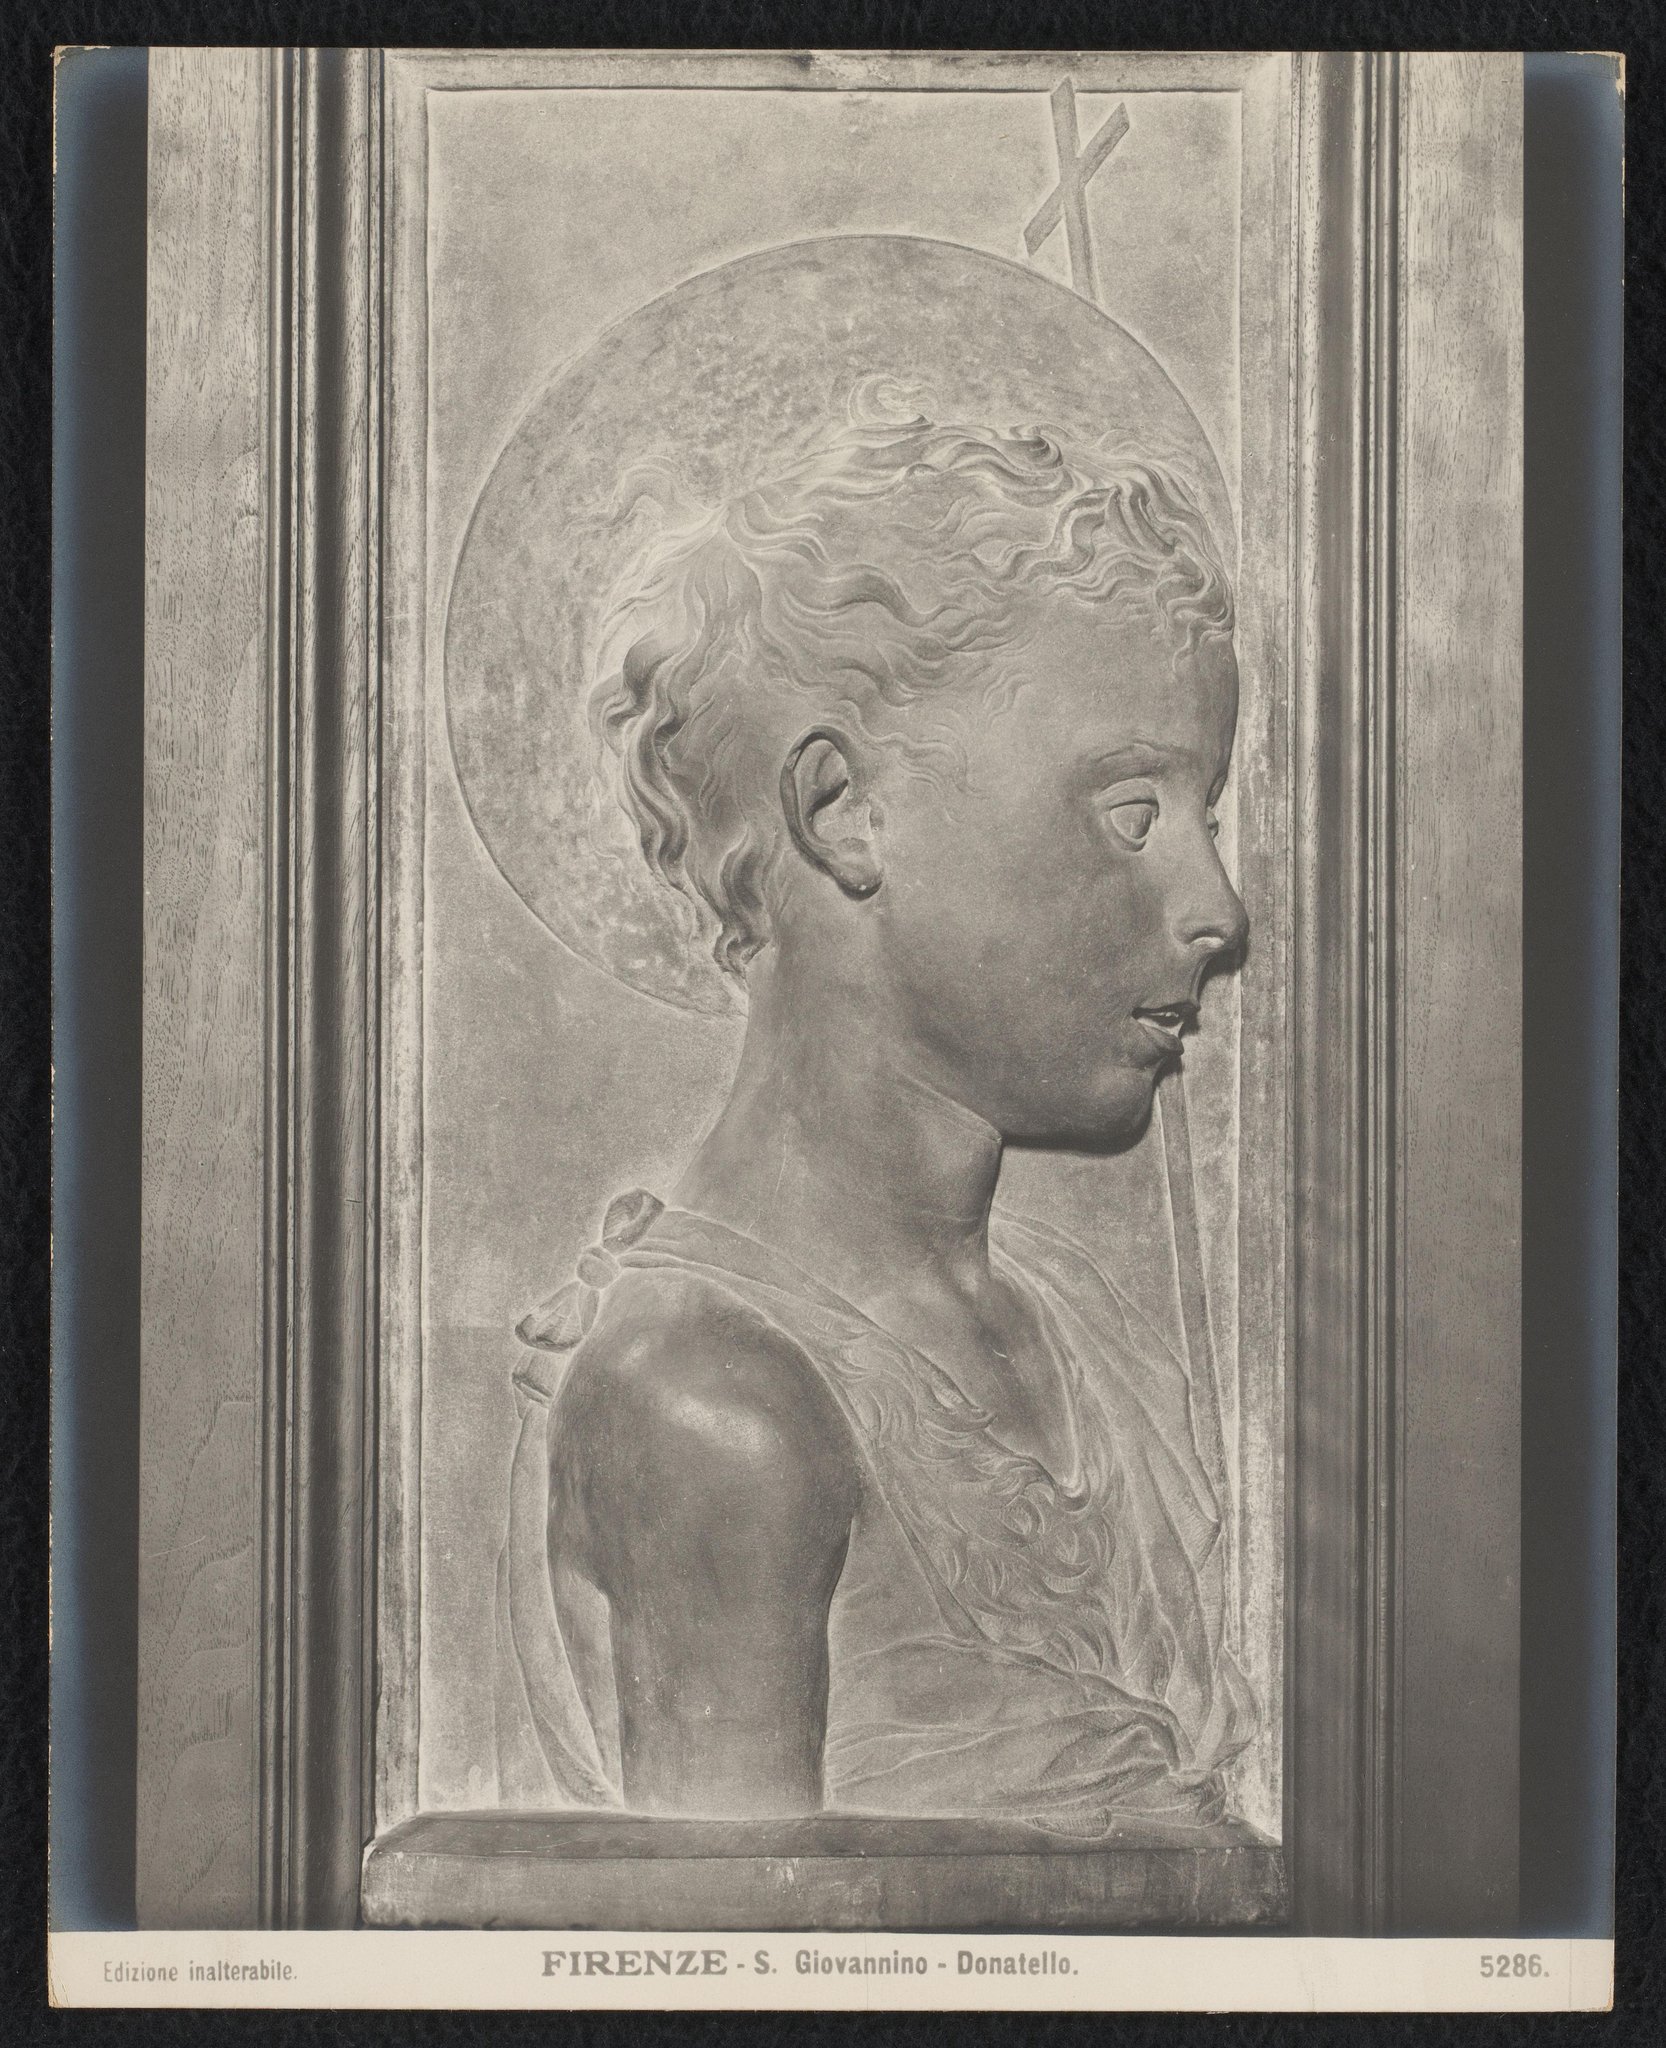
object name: photograph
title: Firenze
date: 1901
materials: paper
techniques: gelatin silver print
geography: berlin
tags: interior ~ representation of a building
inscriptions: collector's mark: ‘RIJKS SCHOOL VOOR KUNSTNIJVERHEID/ GROEP’, inscription: ‘Edizione inalterabile.’, number: ‘5285.’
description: Deze foto maakt deel uit van een omslag.